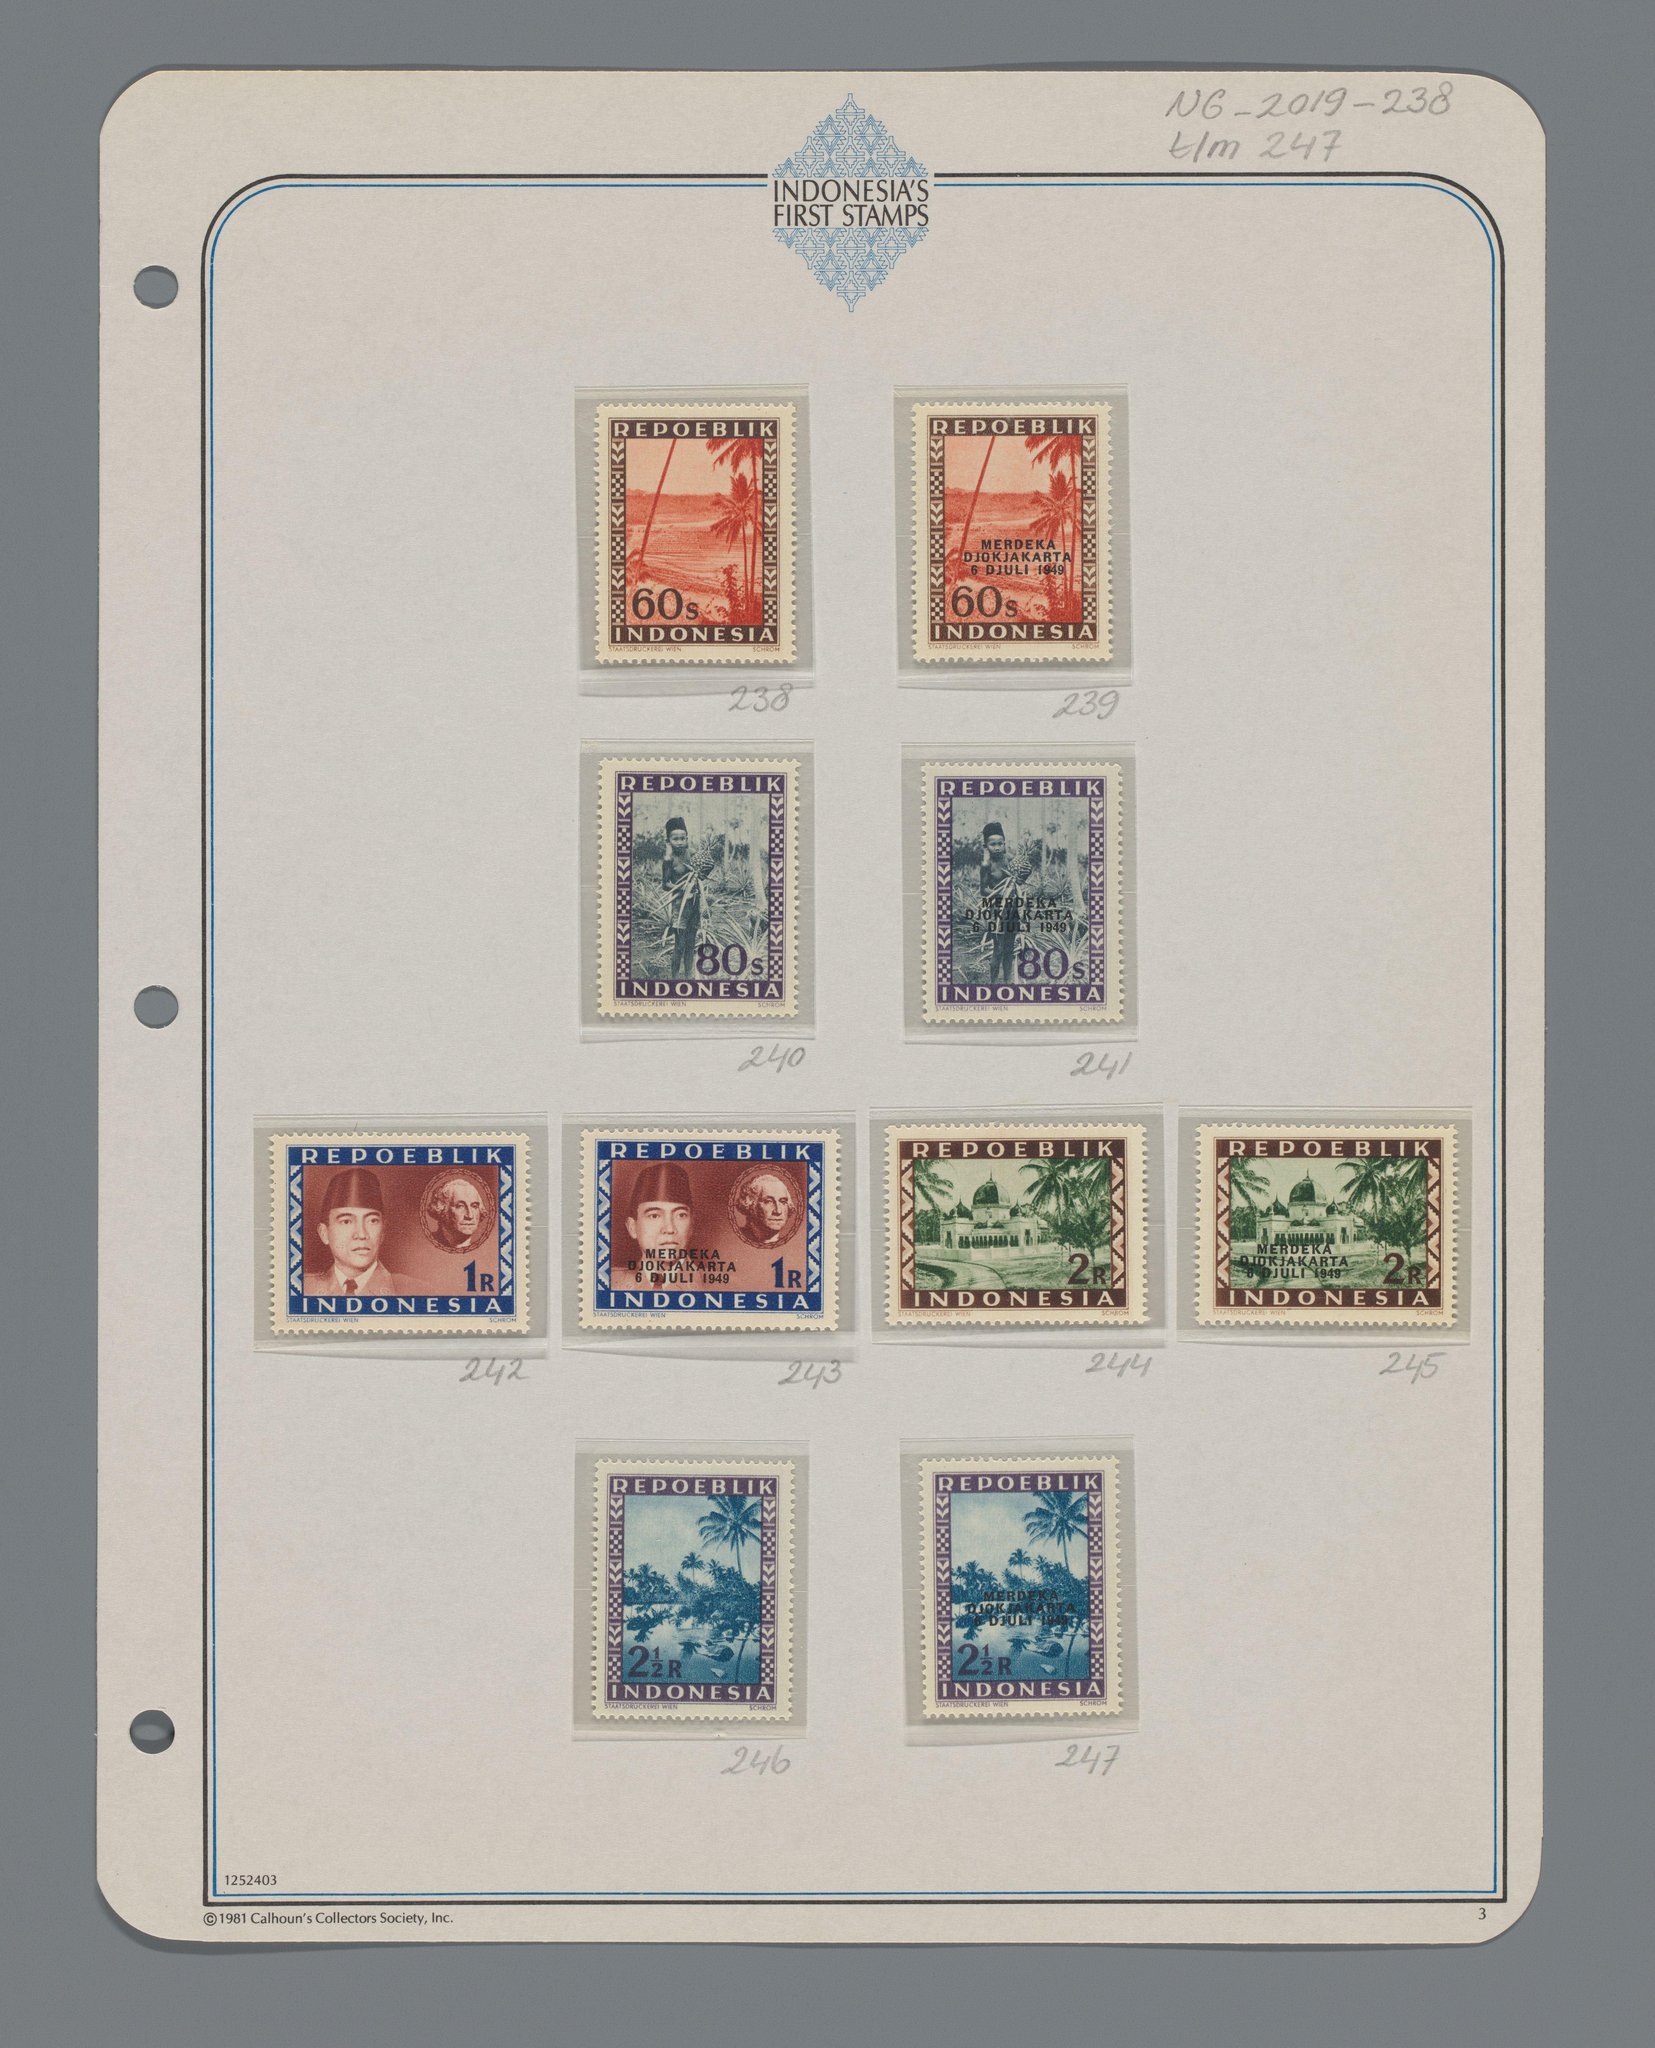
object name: postage stamp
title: Postzegel Republik Indonesia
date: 1949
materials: paper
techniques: photoaquatint, engraving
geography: philadelphia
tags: indonesia